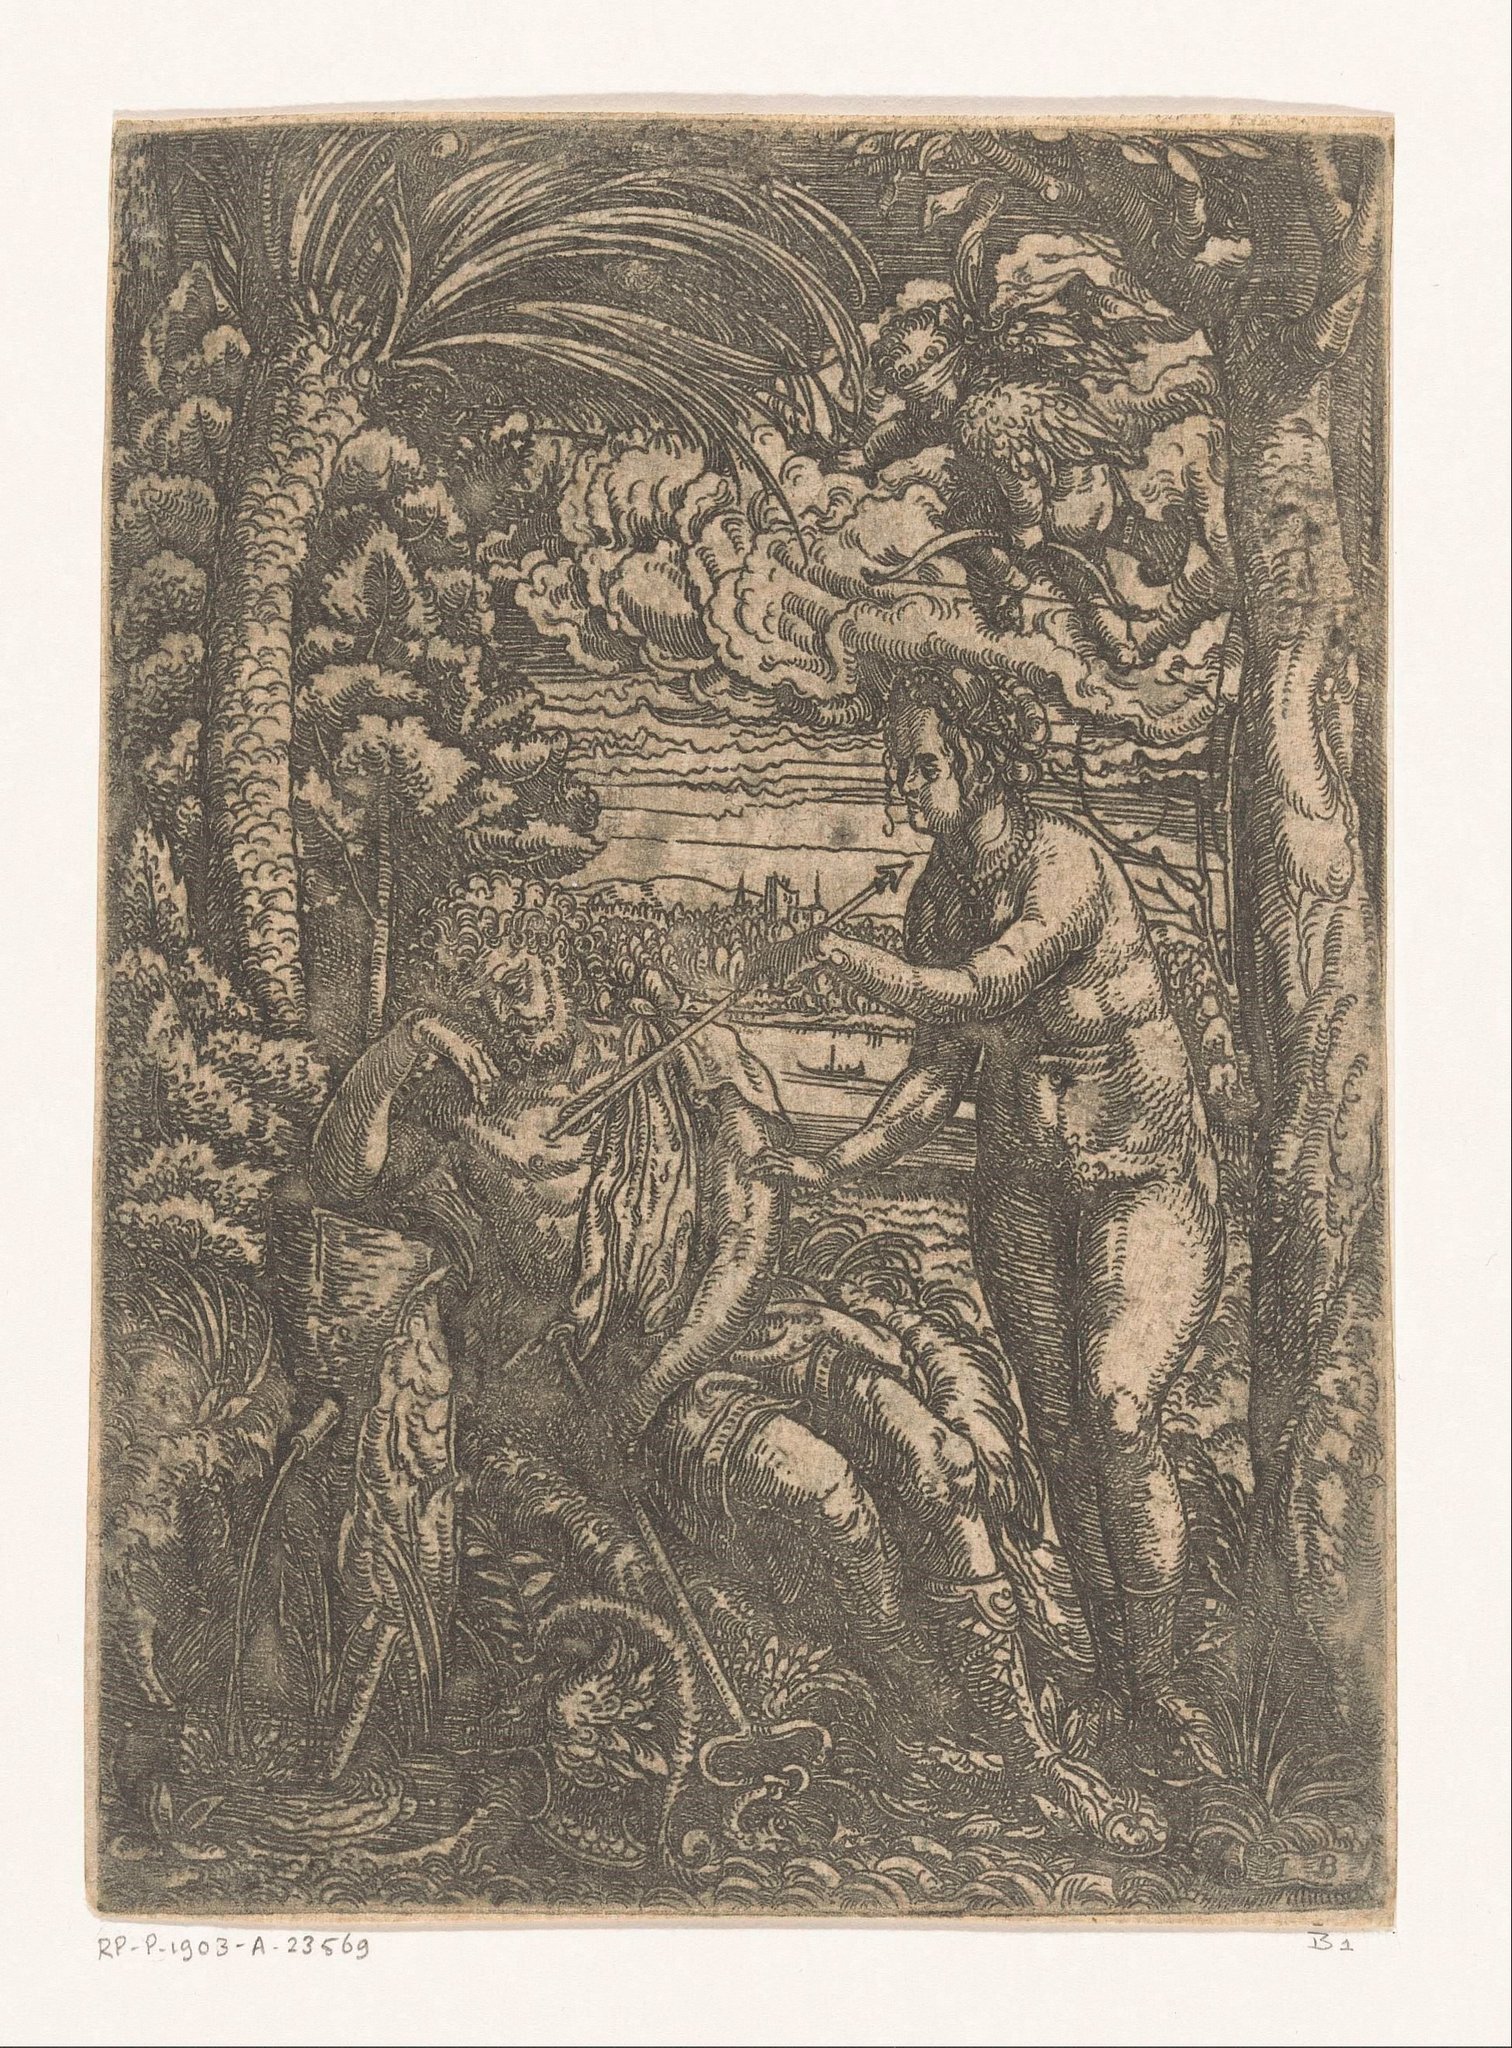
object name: print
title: Venus en Mercurius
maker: hans burgkmair (i)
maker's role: draughtsman, print maker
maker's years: 1473-1531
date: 1520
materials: paper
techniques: etching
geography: augsburg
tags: mercury and venus as lovers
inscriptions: collector's mark: Lugt 2398, collector's mark: Lugt 2228, collector's mark: Lugt 1606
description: Dit is de enige ets die bekend is van Hans Burgkmair de Oudere. Mogelijk ging het om een eenmalig experiment. In het verleden is de prent ook wel toegeschreven aan zijn zoon, Hans Burgkmair de Jongere. De originele plaat, vervaardigd uit staal, bevindt zich in het British Museum (inv. nr. 1862,1011.184). Van deze plaat zijn tot in de negentiende eeuw afdrukken gemaakt.